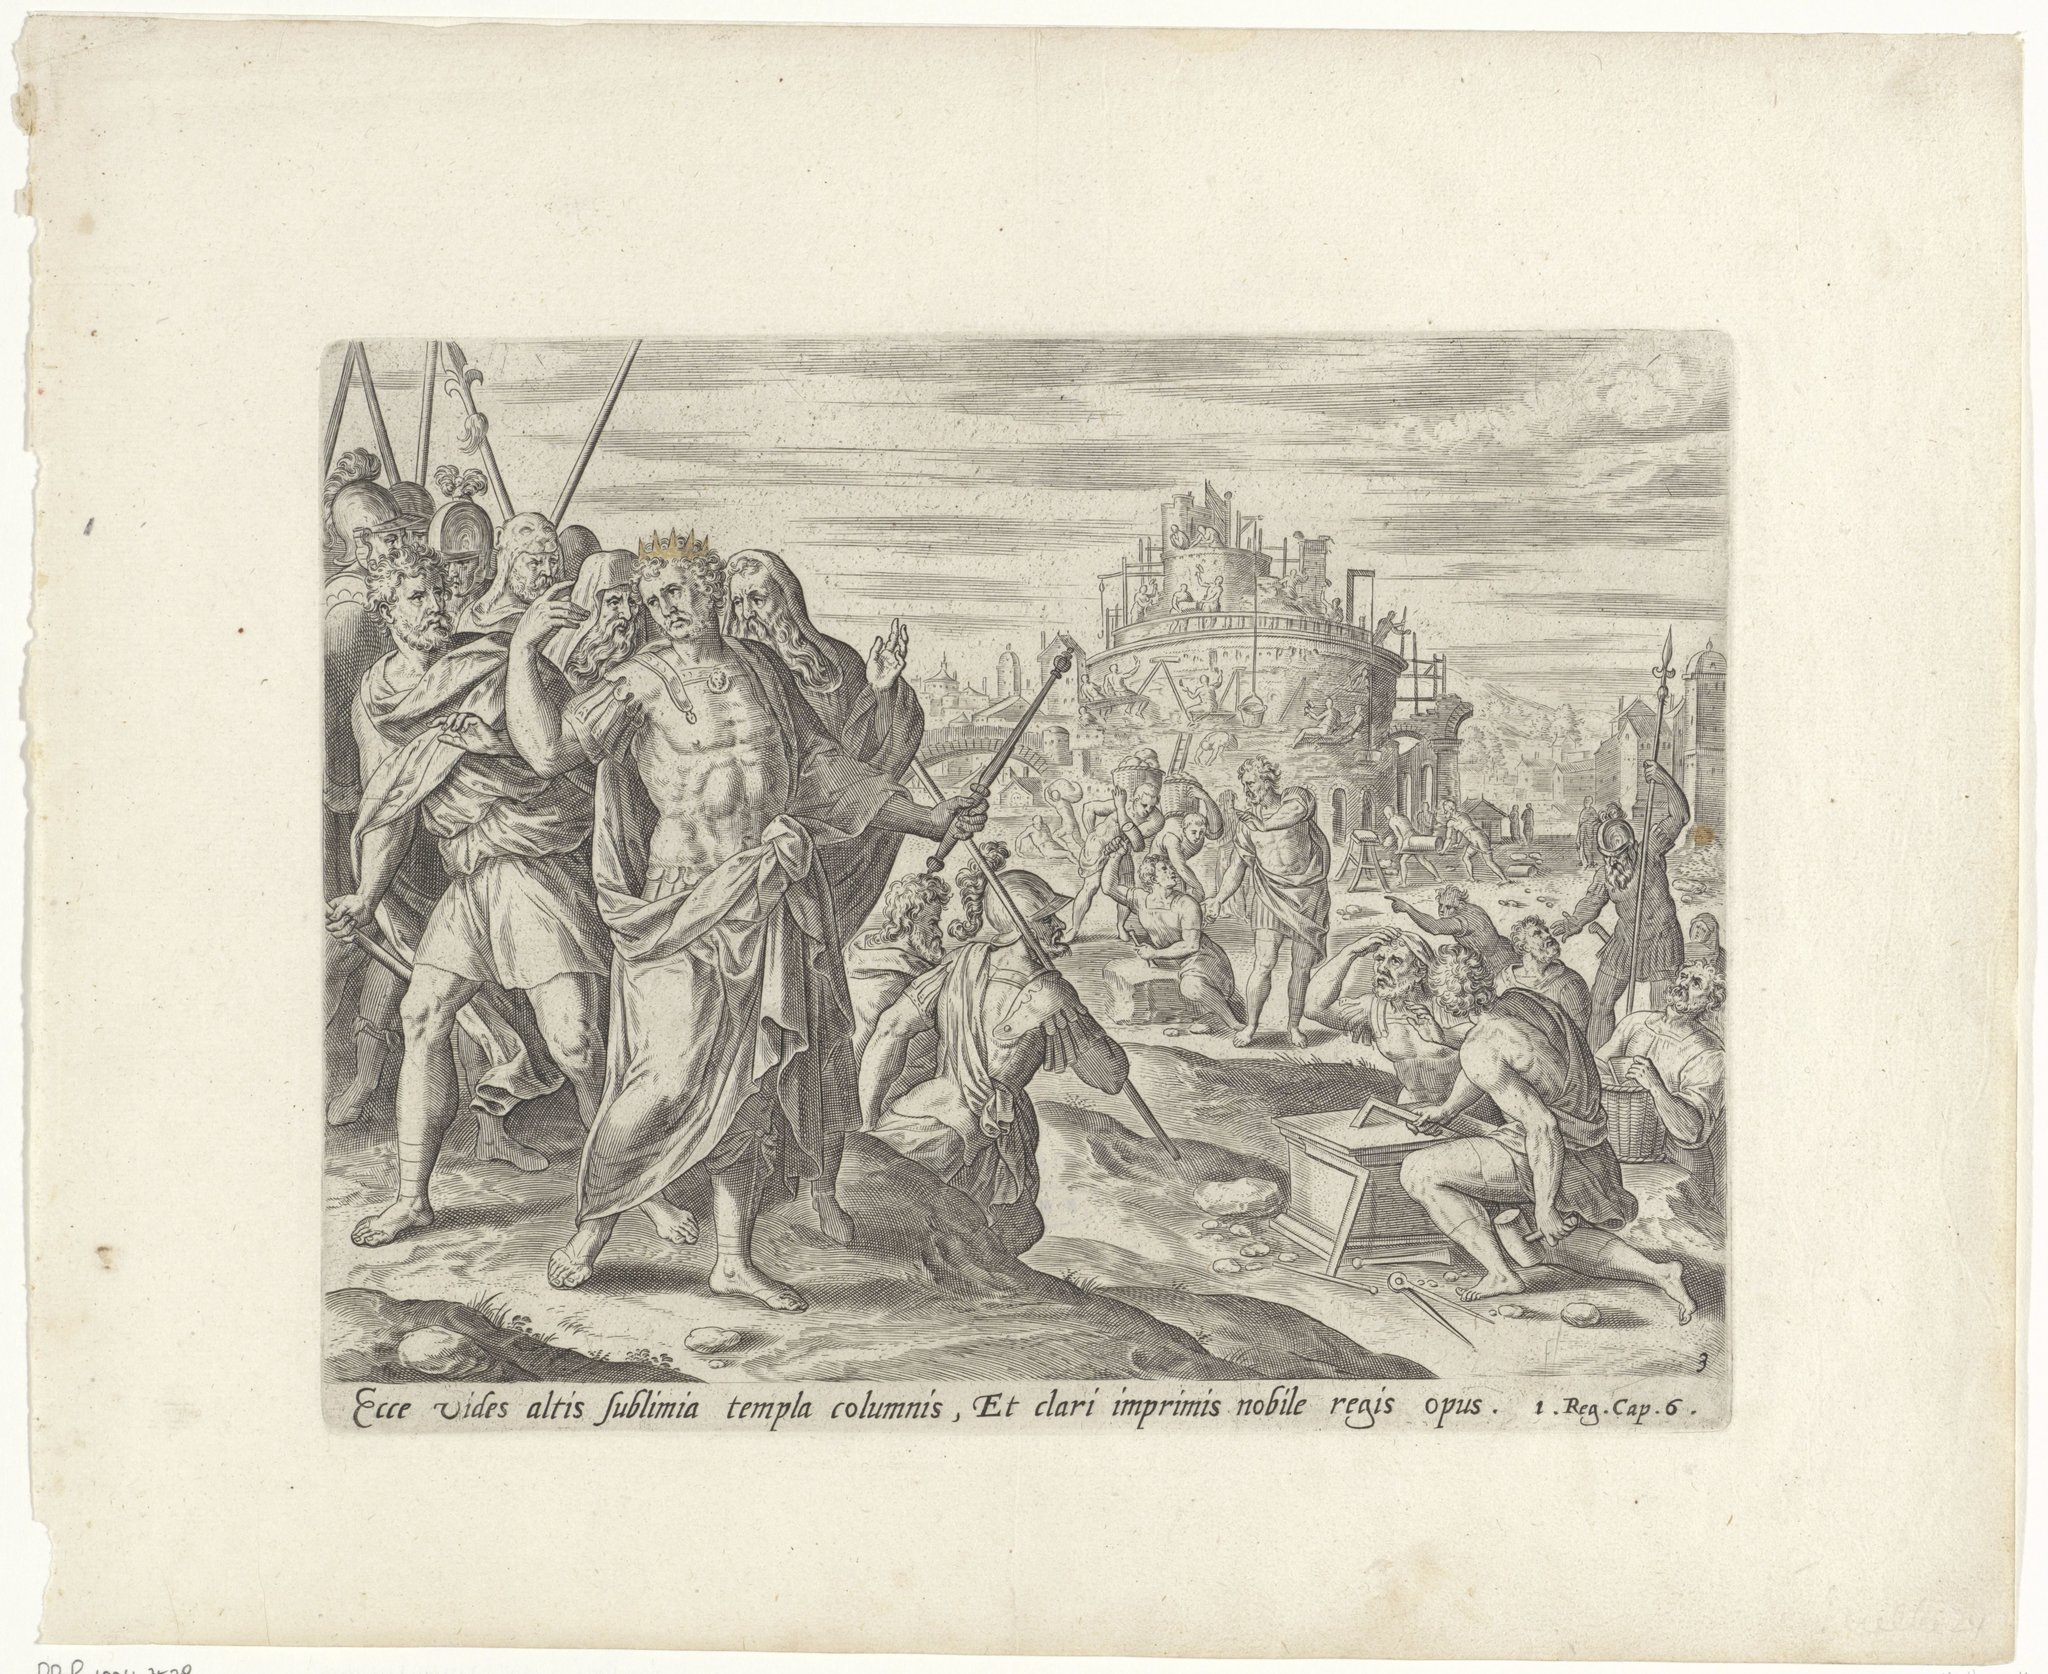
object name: print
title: Theatrum biblicum (...)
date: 1579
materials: paper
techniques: engraving, hand coloring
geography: amsterdam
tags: solomon supervising the work ~ temple of solomon, building-site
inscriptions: collector's mark: Lugt 2228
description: Deze staat wordt niet beschreven in The New Hollstein. De prent mist de 1 als aanduiding van het Bijbelvers, maar is wel genummerd en uitgegeven door Claes Jansz. Visscher (II).. Latere staat van prent gebruikt in: Theatrum biblicum : hoc est historiae sacrae veteris et novi testamenti tabulis aeneis expressae. Opus praesentatissimorum huius ac superioris seculi pictorum atque sculptorum, summo studio conquisitum et in lucem editum. Amsterdam: Claes Jansz. Visscher, 1643.